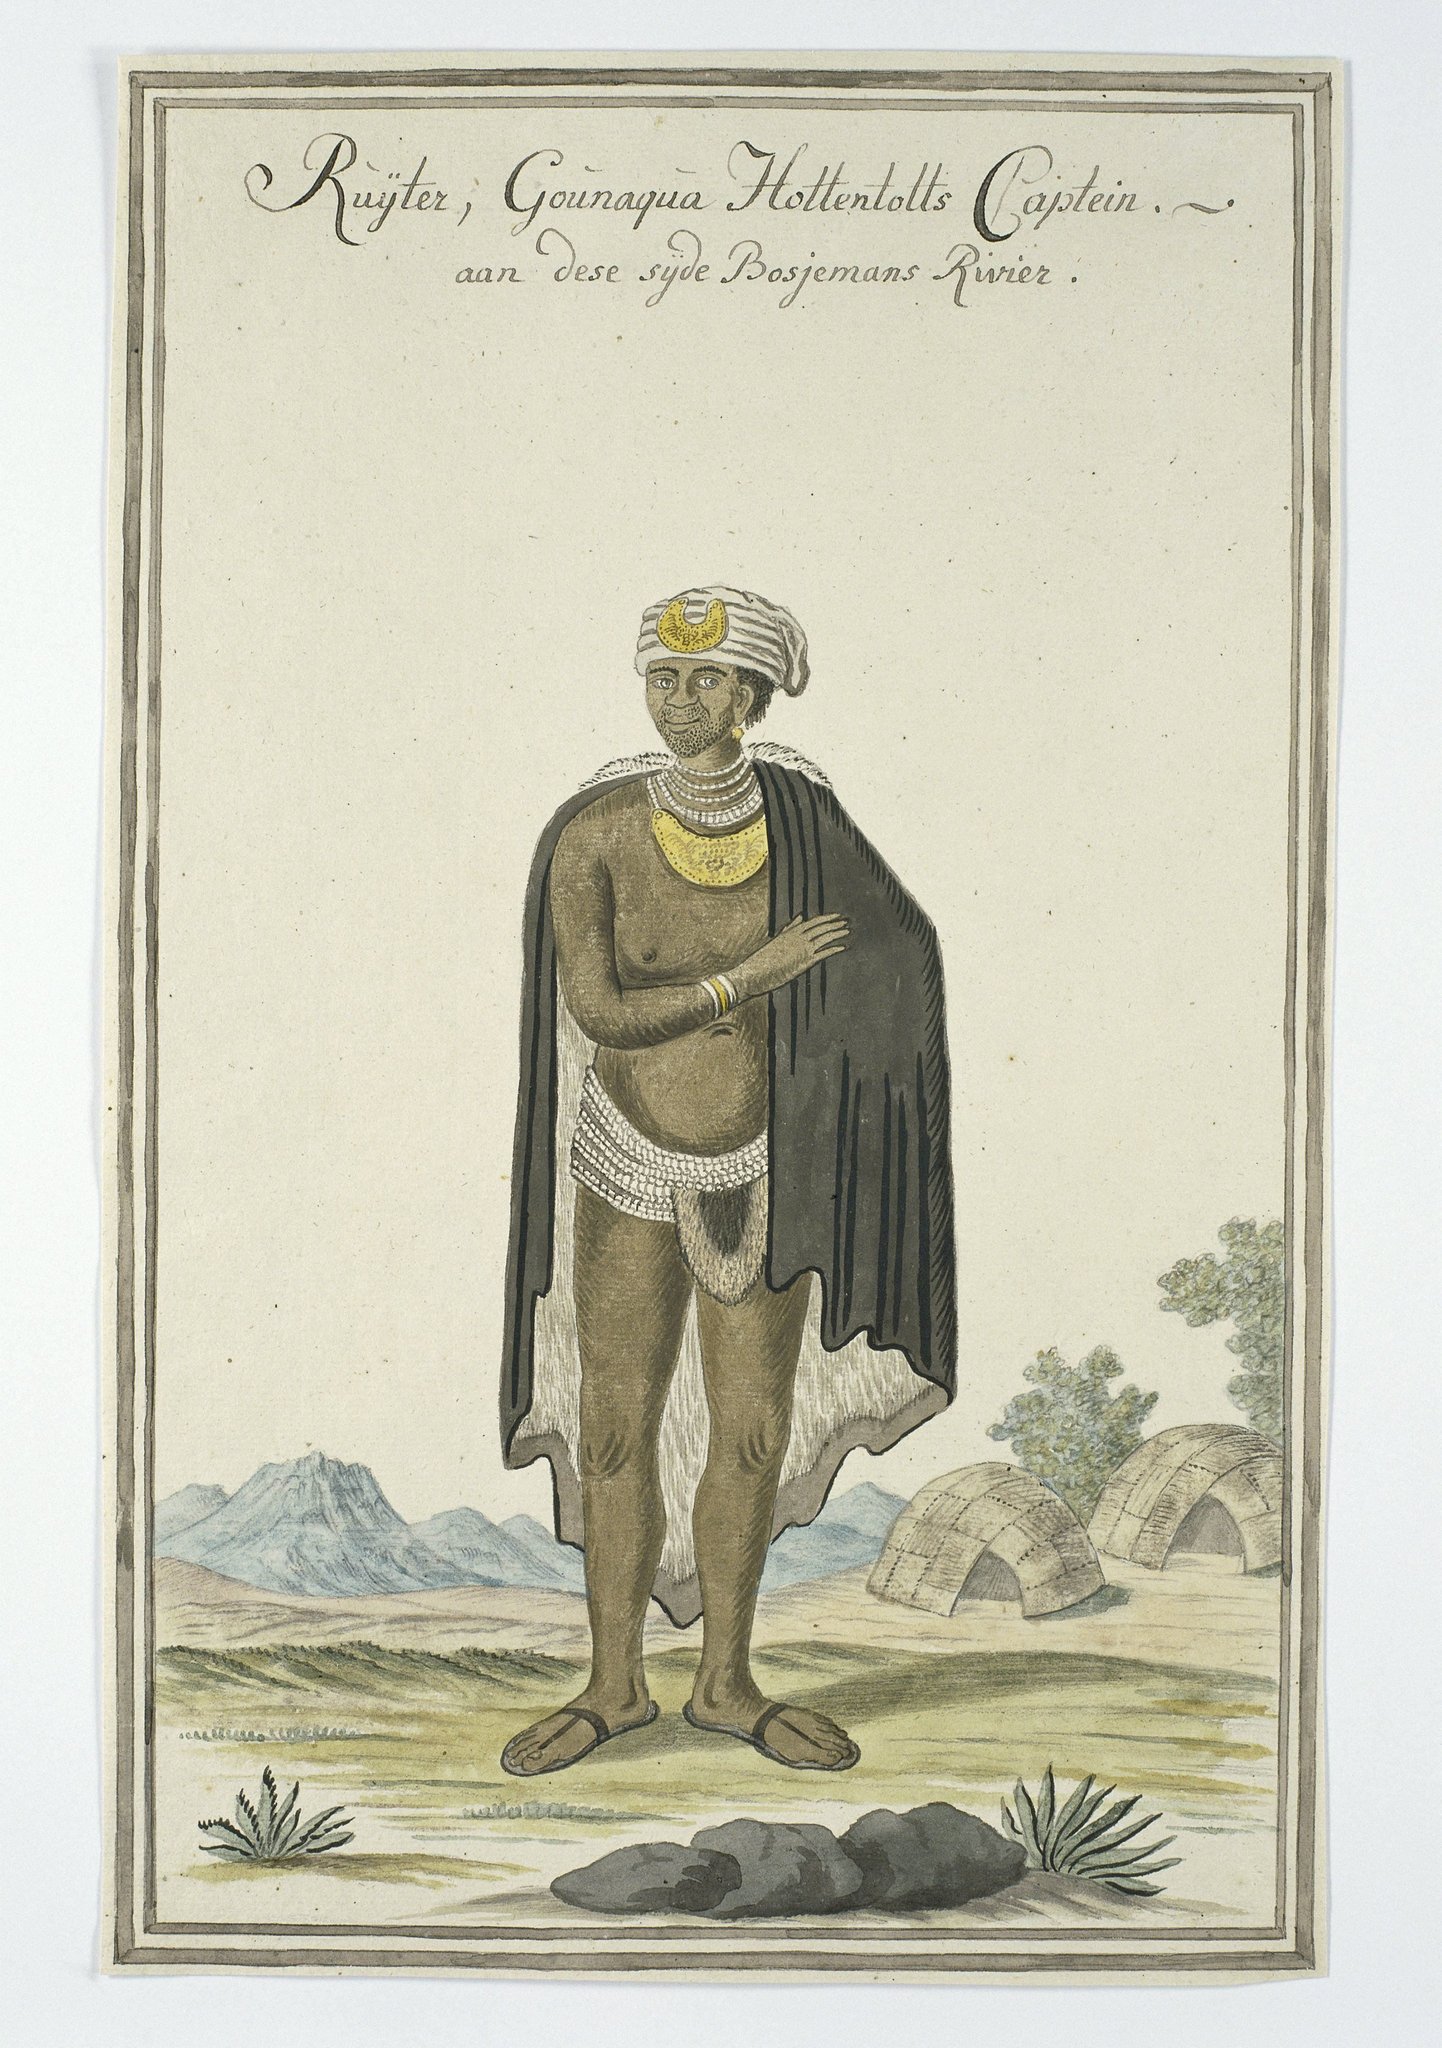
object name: drawing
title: Ruiter, a Gonaqua captain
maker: robert jacob gordon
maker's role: draughtsman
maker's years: 1743-1795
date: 1701-1778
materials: paint, ink, paper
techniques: brush, pen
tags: khoikhoi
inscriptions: annotation: ‘Ruijter, Gounaqua Hottentotts Captein. ~ / aan dese sijde Bosjemans Rivier.’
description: De Khoi opperhoofden Karmoeb en Ruyter Twee Khoi opperhoofden met hun door de VOC geschonken waardigheidsstaf en ringkraag.